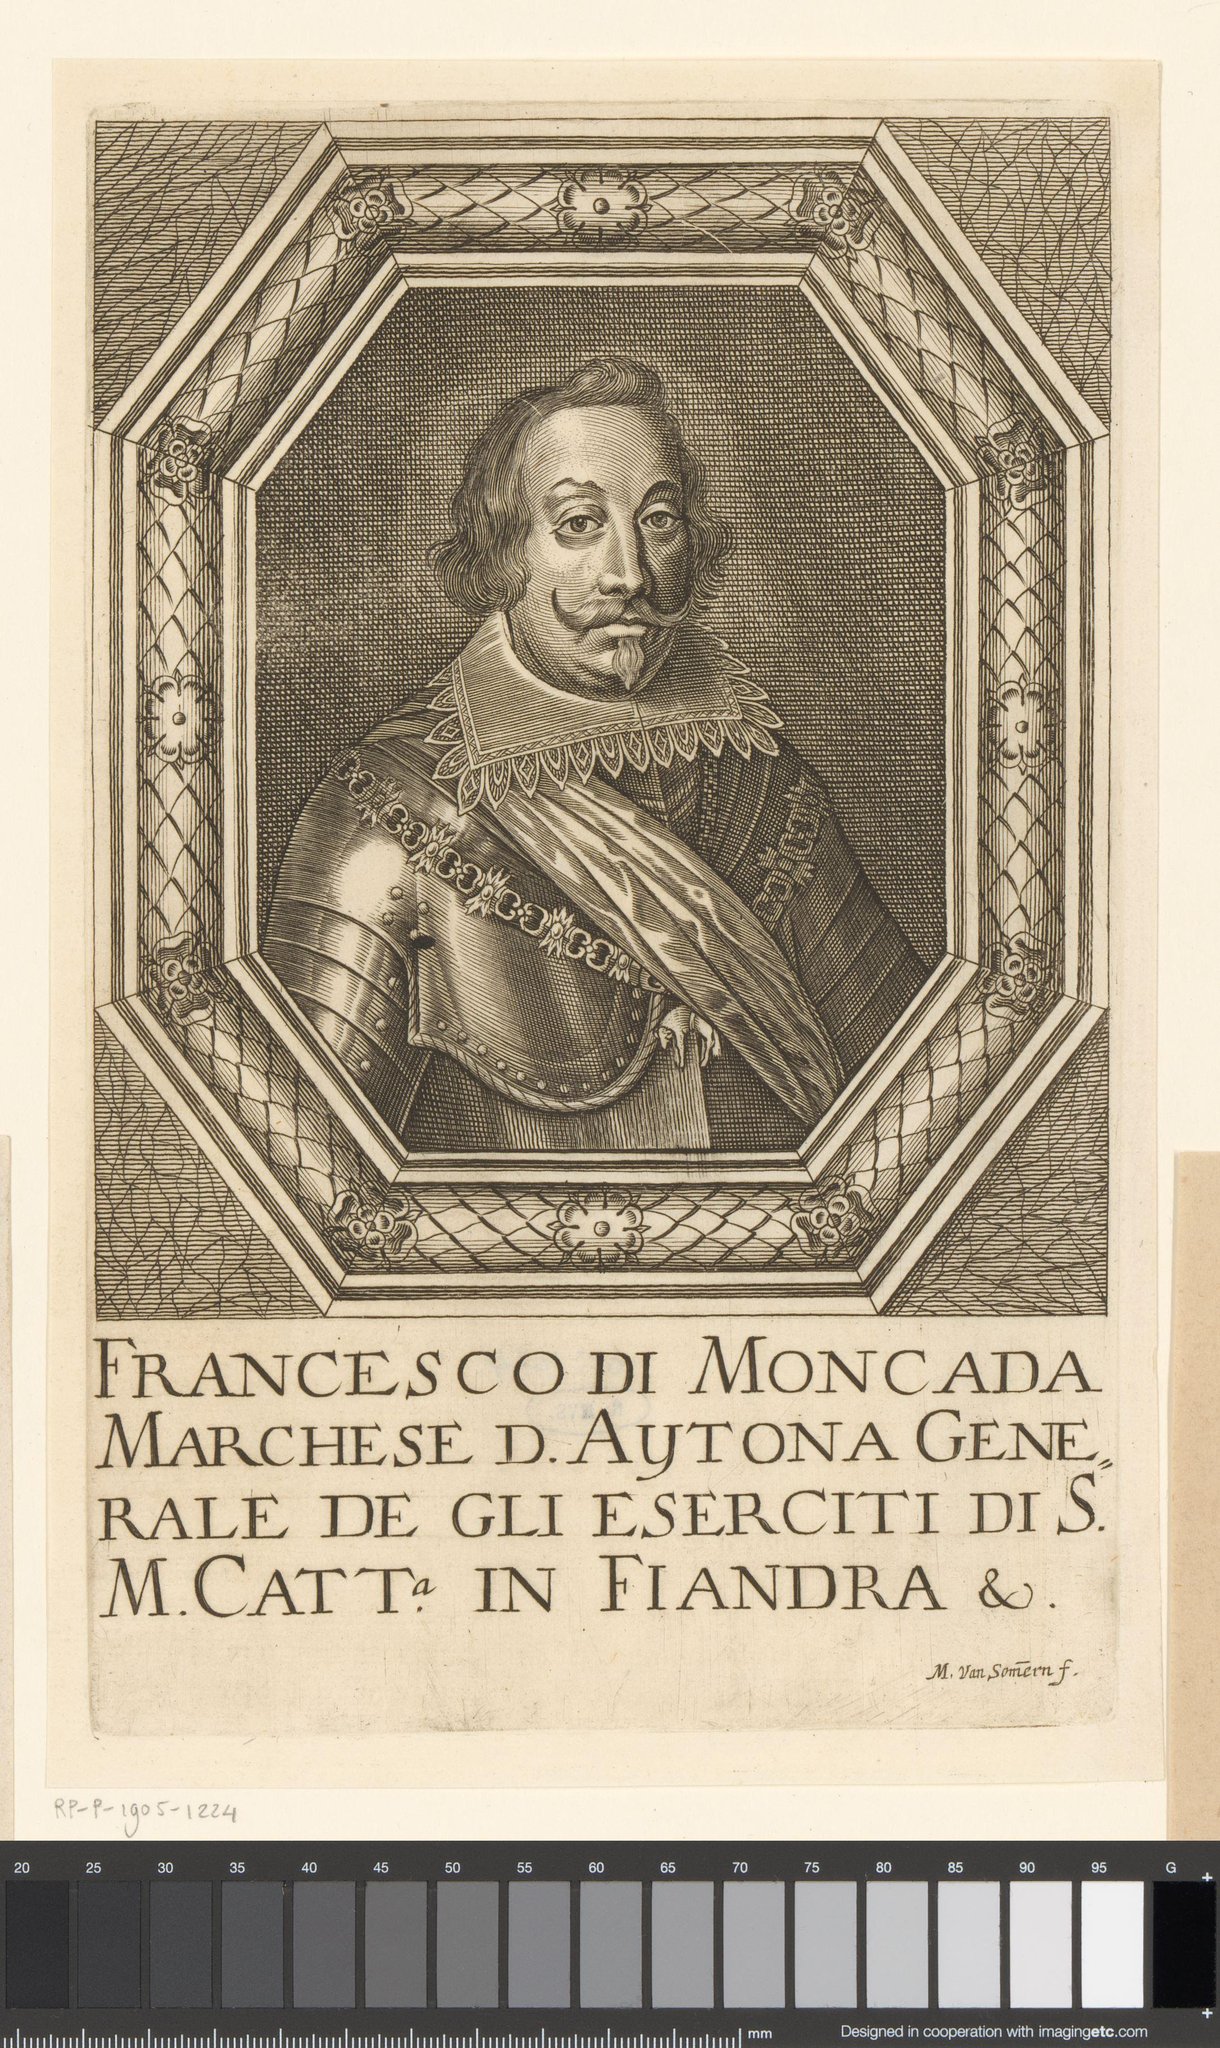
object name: print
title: Portret van Francisco de Moncada, markies van Aytona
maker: matthias van sommer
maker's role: draughtsman, print maker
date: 1672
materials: paper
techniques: engraving, etching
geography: germany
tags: brussels, francisco de moncada (markies van aytona), armour, historical persons, knighthood order of the golden fleece - insignia of a knighthood order, e.g.: badge, chain (with name of order)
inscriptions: collector's mark: Lugt 2228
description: Prent gebruikt voor de publicatie: Gualdo Priorato, Galeazzo. Historia Di Ferdinando Terzo Imperatore. Wenen: Matteo Cosmerovio, 1672.